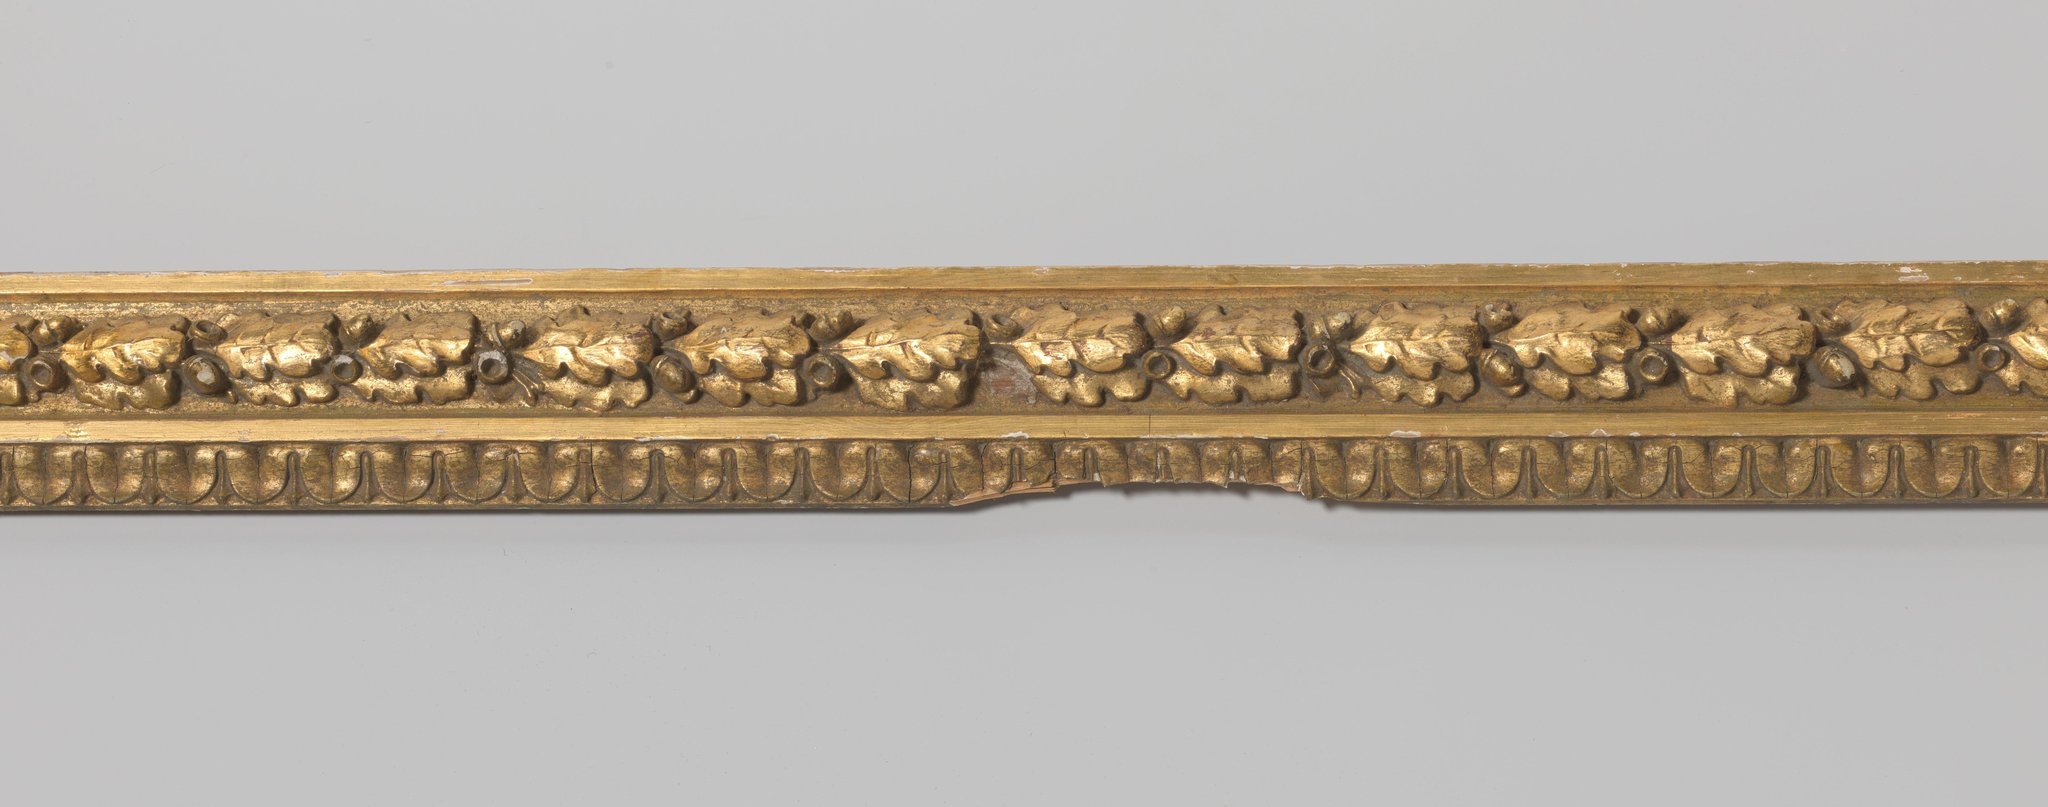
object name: frame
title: Lijstfragment: vergulde lijst met pâte-ornamenten, onderregel deel 2.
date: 1700-1899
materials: gold leaf, wood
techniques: gilding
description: Vergulde lijst met eikenbladeren met eikeltjes. Lijstdeel, deel van de onder regel. Met achterop geschreven: 'No.3'.